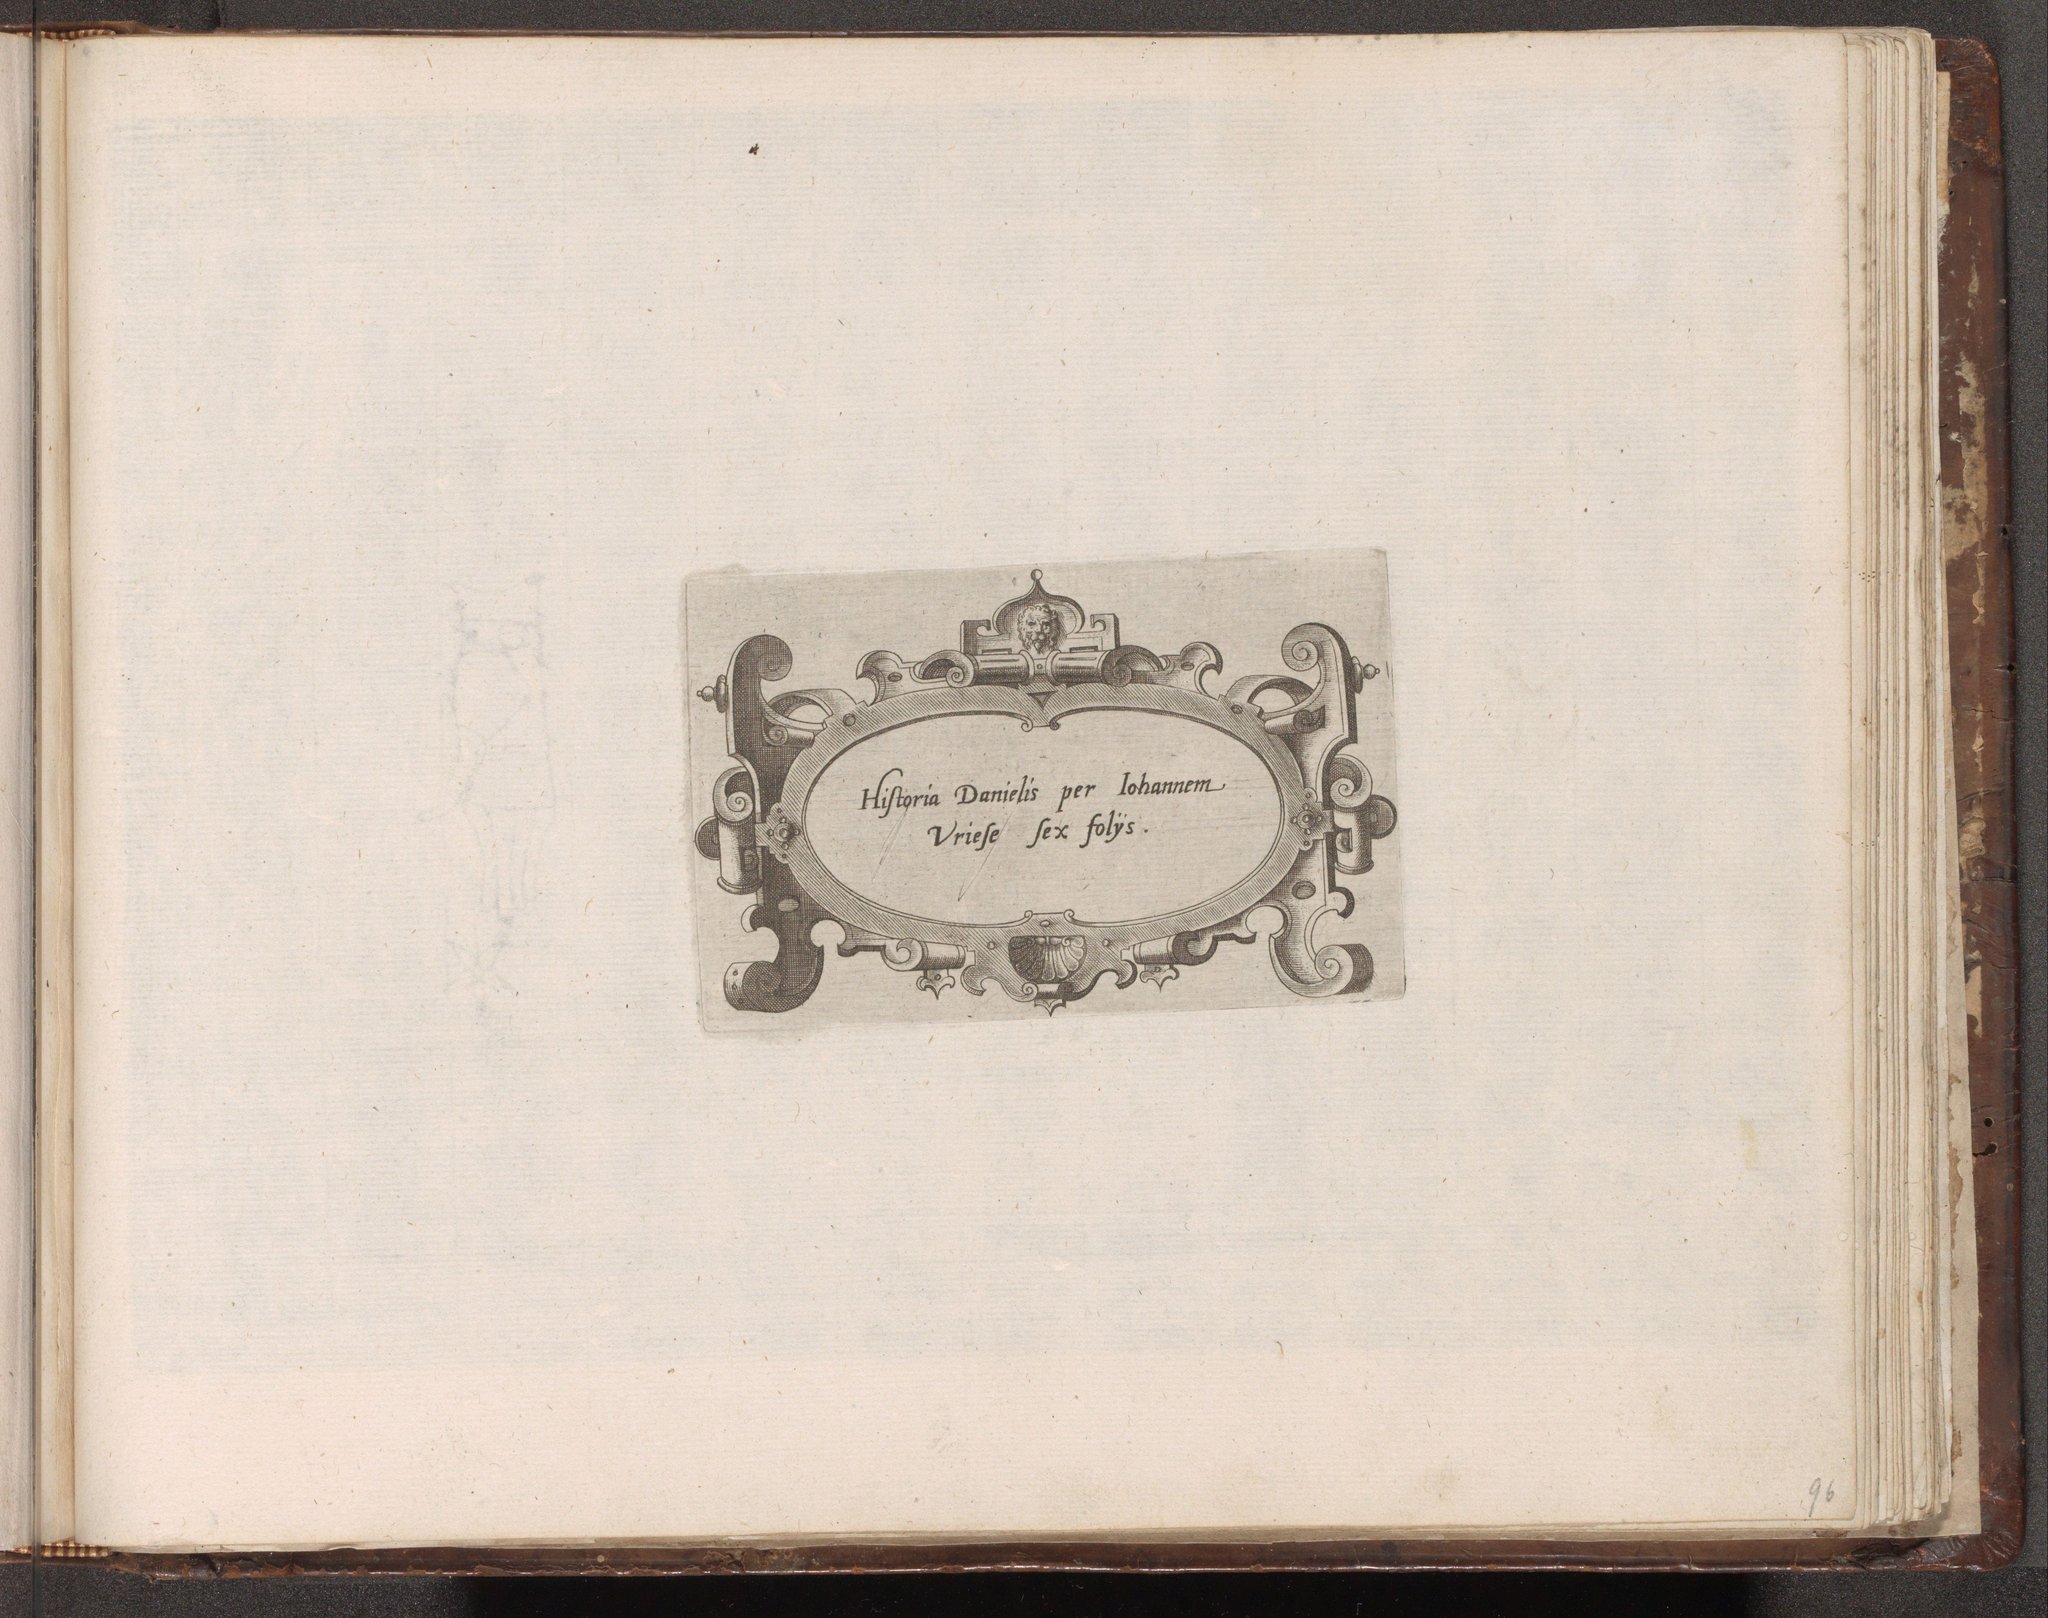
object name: print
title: Geschiedenis van Daniël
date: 1579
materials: paper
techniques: engraving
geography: antwerp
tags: scrollwork, strapwork ~ ornament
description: Titel in cartouche met rolwerk. Titelprent voor een serie prenten over de geschiedenis van Daniël. Prent maakt deel uit van een album.